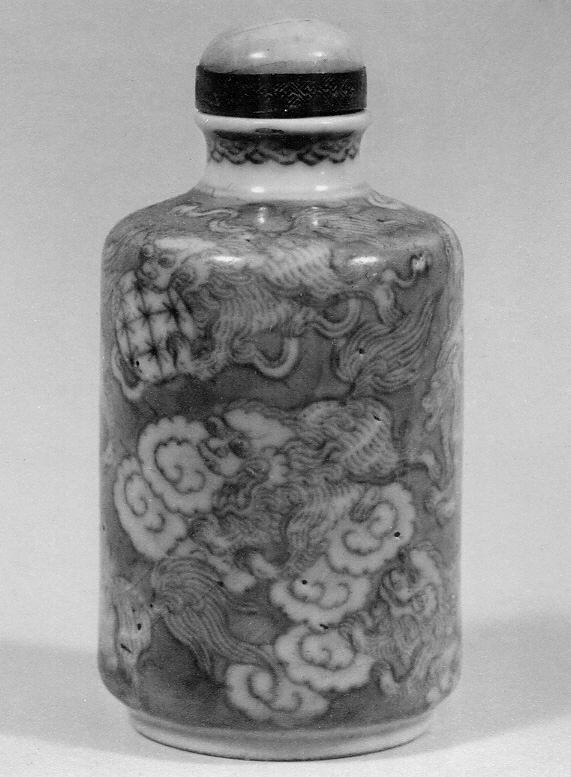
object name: snuff bottle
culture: chinese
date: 1723-1735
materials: porcelain